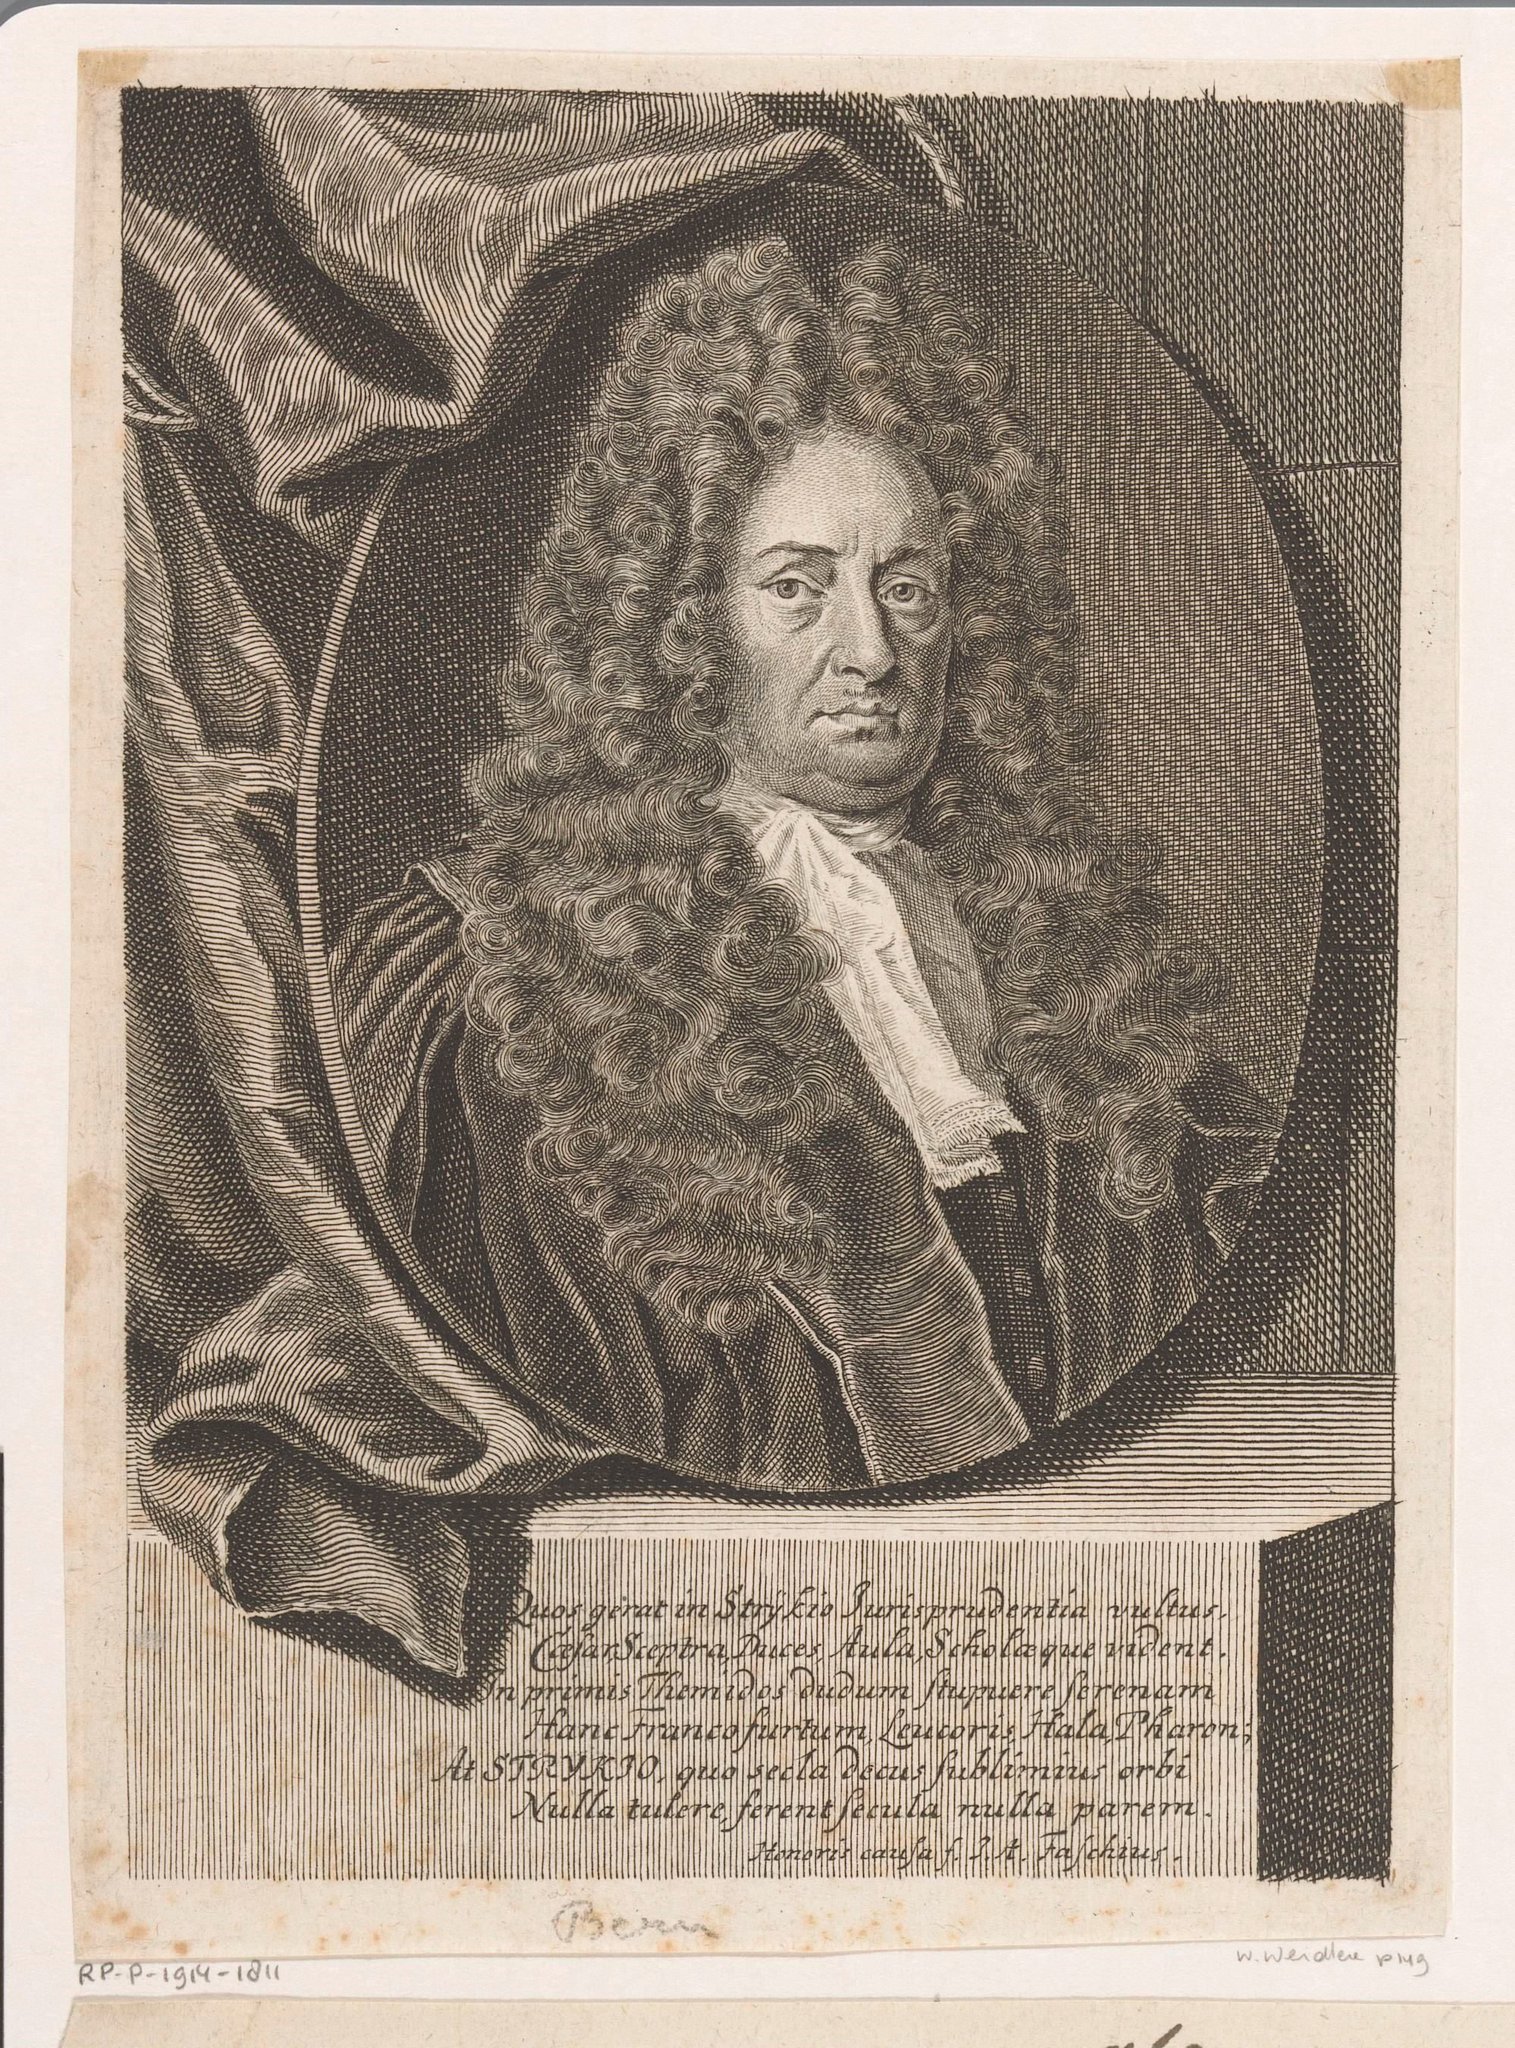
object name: print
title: Portret van Samuel Stryk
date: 1692-1733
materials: paper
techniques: engraving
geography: halle an der saale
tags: samuel stryk, historical persons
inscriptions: collector's mark: Lugt 2228